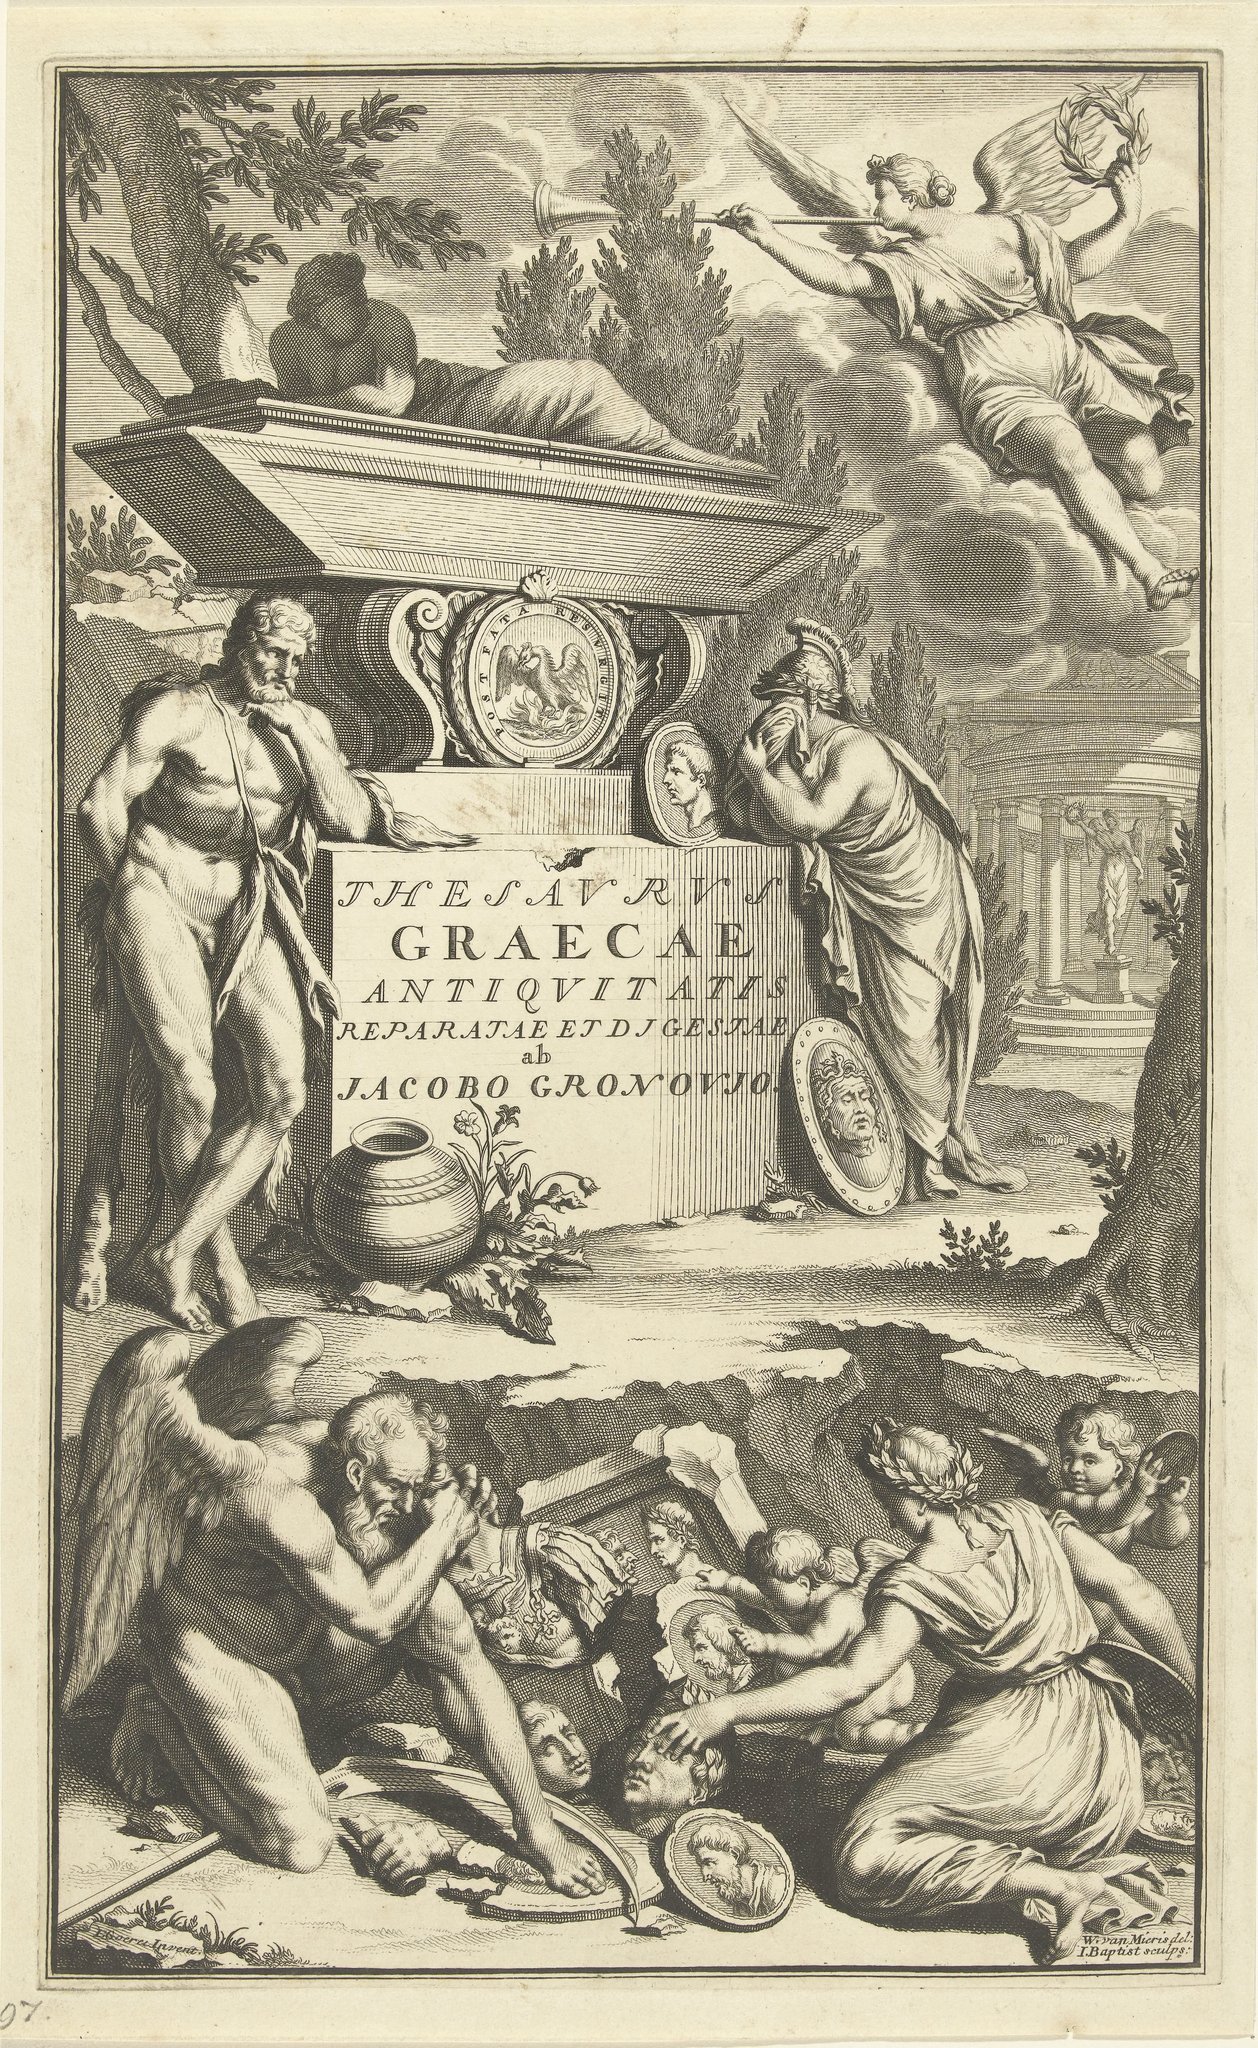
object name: titelblad, titelpagina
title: Titelpagina voor: Jacobus Gronovius, Thesavrvs Graecarvm antiqvitatvm, Leiden 1697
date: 1697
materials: paper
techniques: engraving, etching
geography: amsterdam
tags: gods ~ classical mythology (+ suffering, misfortune)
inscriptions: collector's mark: Lugt 240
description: titelpagina voor het eerste deel van: Jacobus Gronovius, Thesavrvs Graecarvm antiqvitatvm, Leiden, Van der Aa, 1697-1702